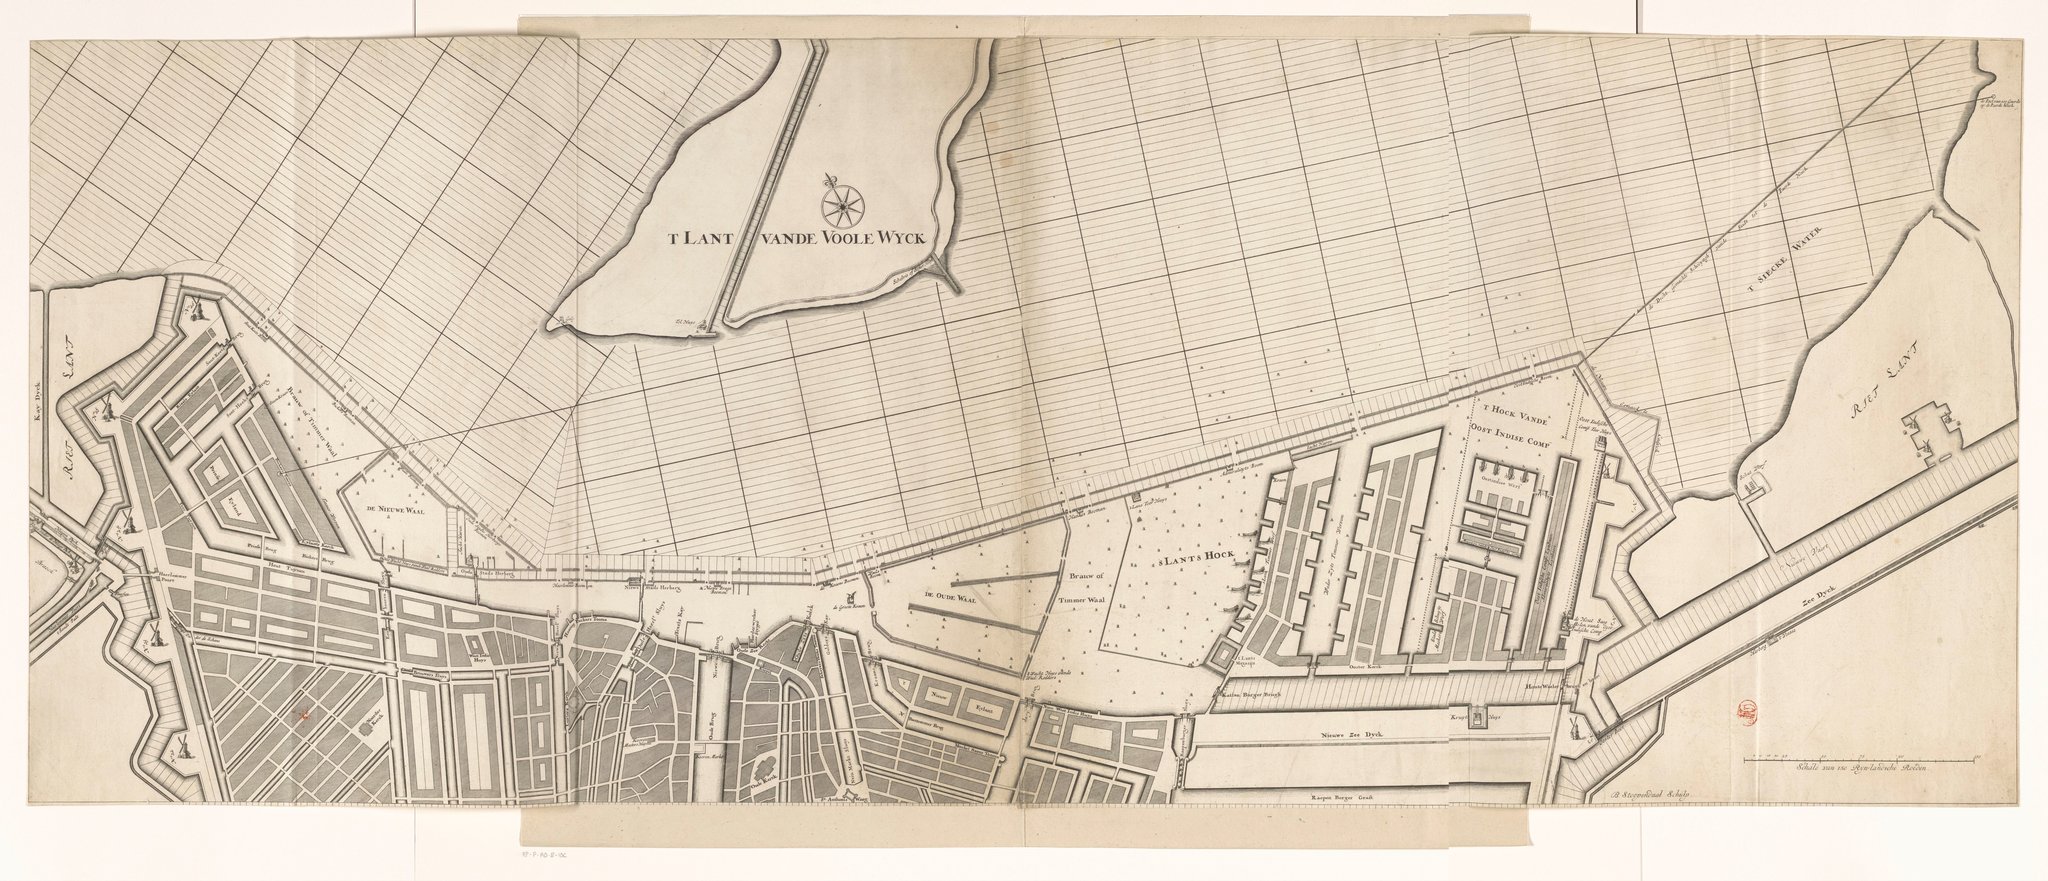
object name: map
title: Kaart van een deel van Amsterdam en het IJ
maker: bastiaen stopendael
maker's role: print maker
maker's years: 1636-1693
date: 1646-1693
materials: paper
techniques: engraving, etching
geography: amsterdam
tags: maps of separate countries or regions, river, maps of cities, amsterdam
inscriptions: collector's mark: Lugt 195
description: Mogelijk is deze kaart deel van een grotere kaart en vormen deze twee aan elkaar geplakte bladen het onderste deel. Er zouden dan aan de bovenkant nog twee bladen horen, zodat een groter deel van het IJ zichtbaar is. Door de strepen die in het water zijn aangebracht kan verondersteld worden dat deze kaart bedoeld was voor het weergeven van dieptemetingen.